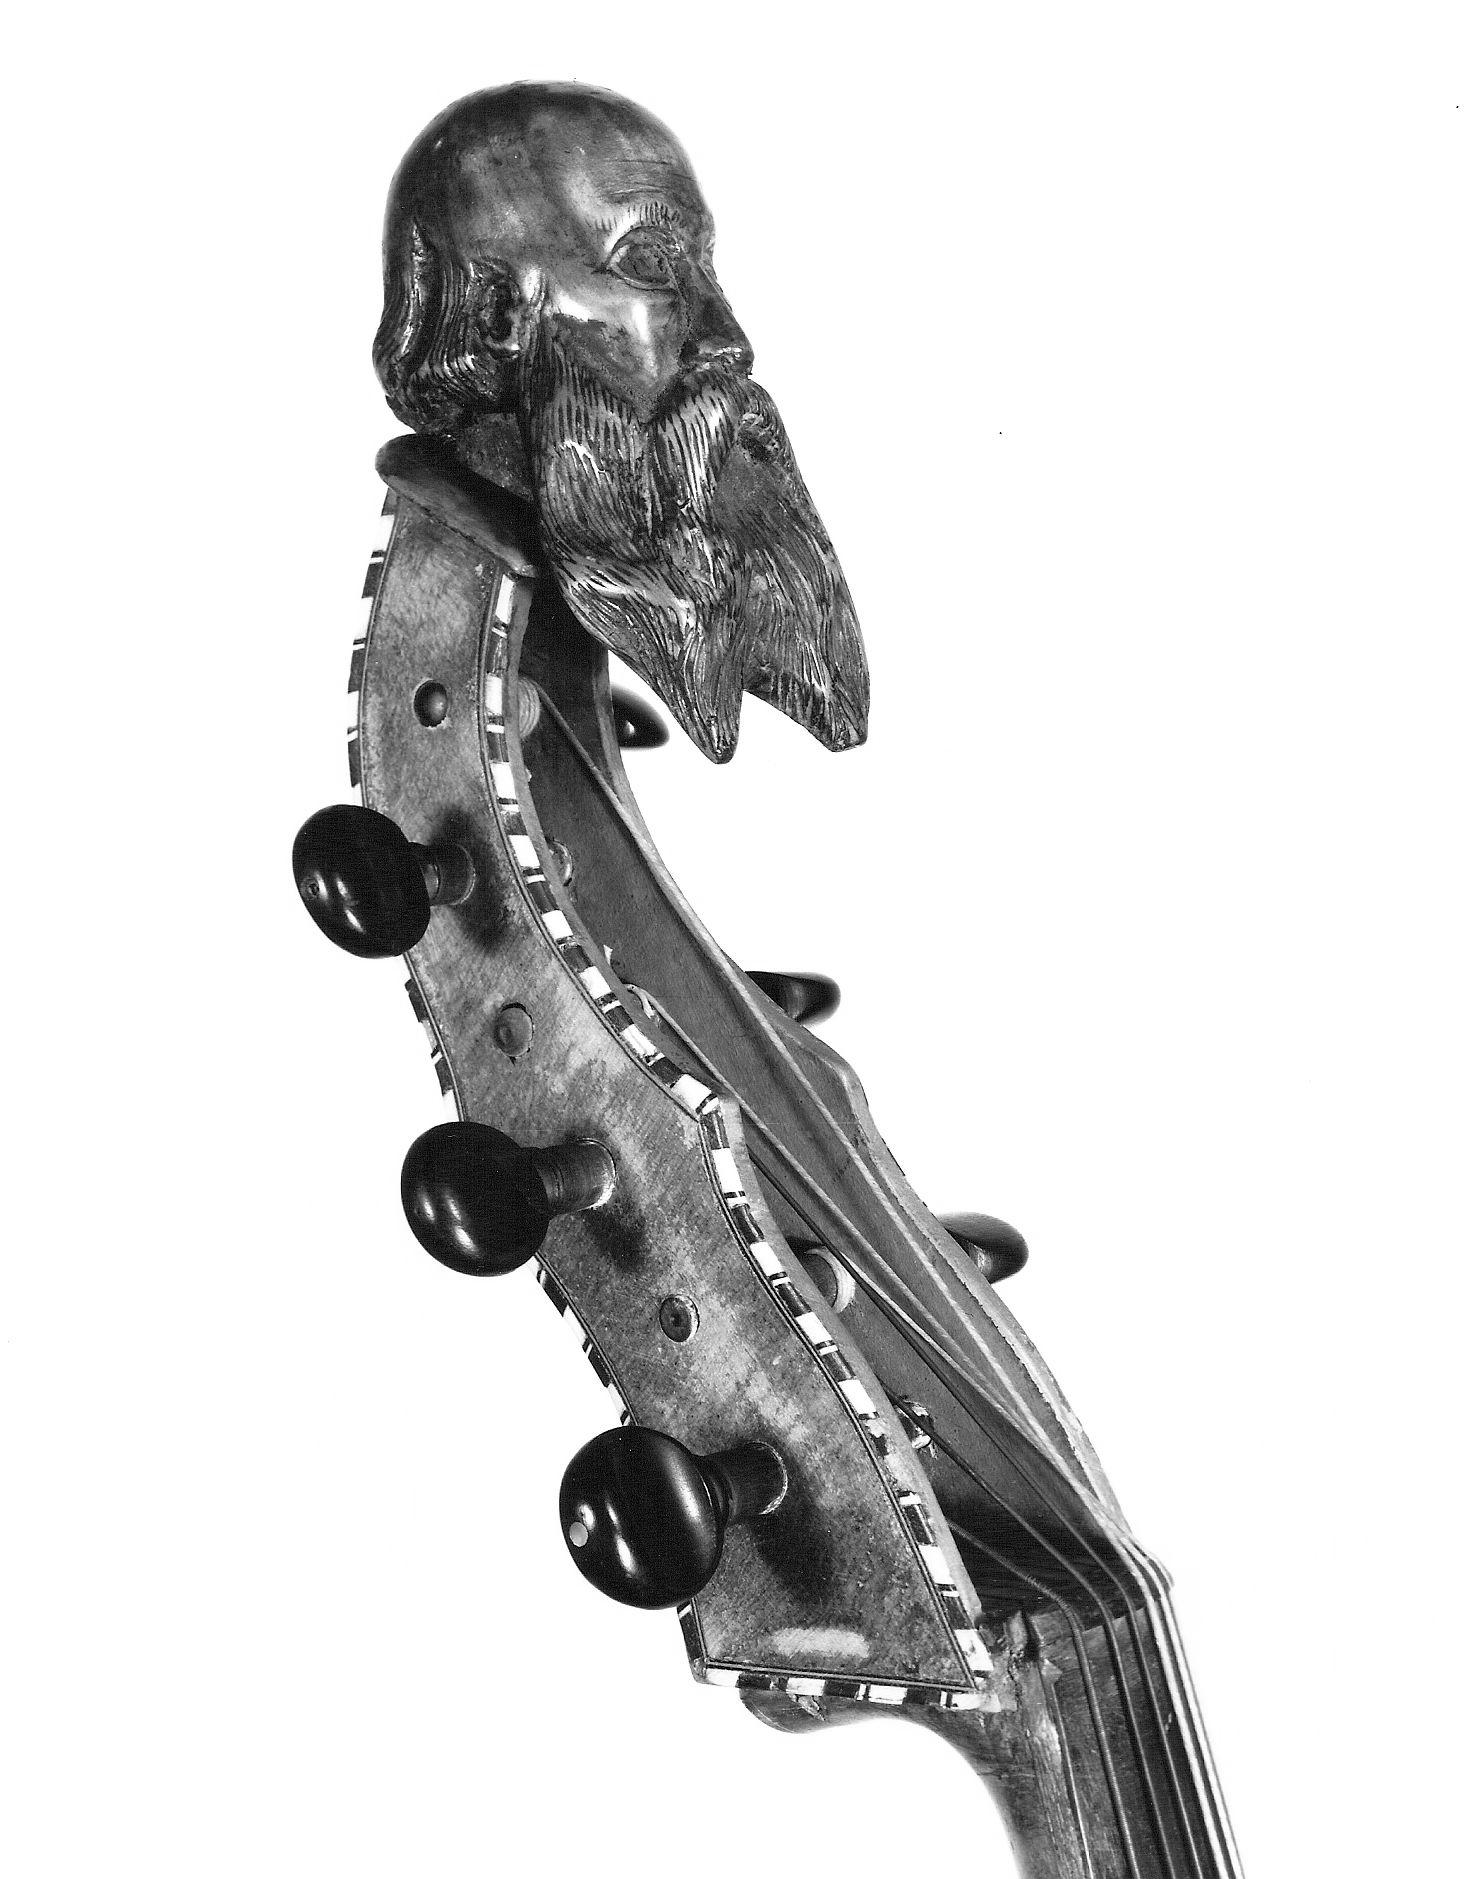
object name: small tenor viol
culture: french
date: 1867-1900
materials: bone, wood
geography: france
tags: heads,men